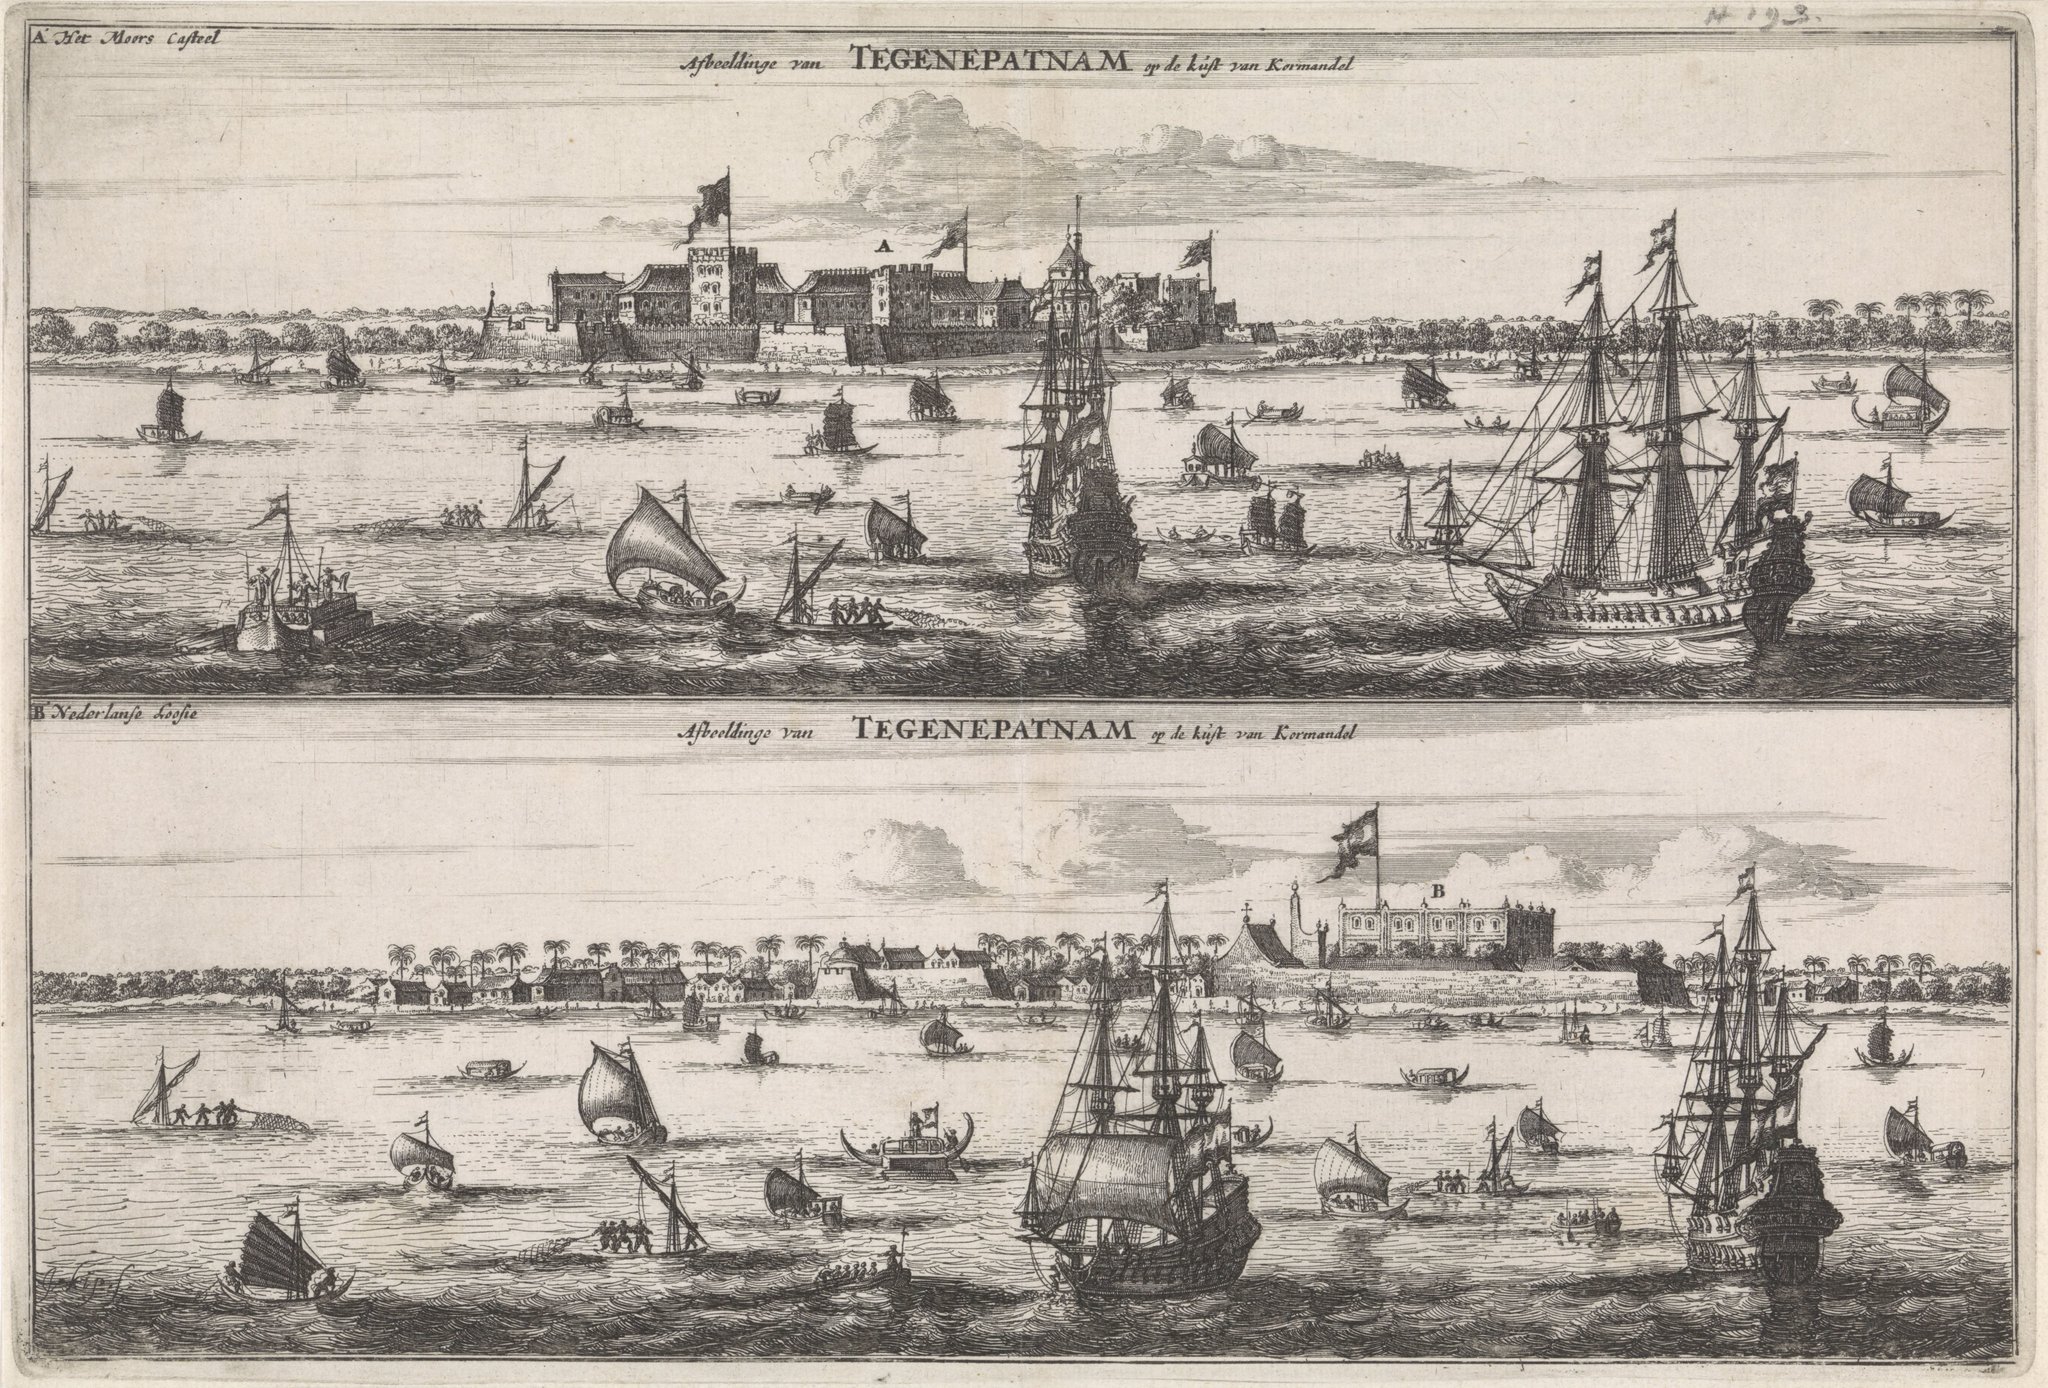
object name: print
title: Gezicht op Tegepatnam, een Moors kasteel en de Nederlandse loge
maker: johannes kip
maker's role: print maker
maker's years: 1652-1722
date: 1676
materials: paper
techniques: etching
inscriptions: collector's mark: Lugt 2760, collector's mark: Lugt 2228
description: Blad met twee gezichten op de stad Tegenepatnam. Boven een gezicht op de fortificatie, met de tekst: 'A Het Moors Casteel'; Onder een gezicht op de stad, met de tekst: 'B Nederlandse Loosie'.